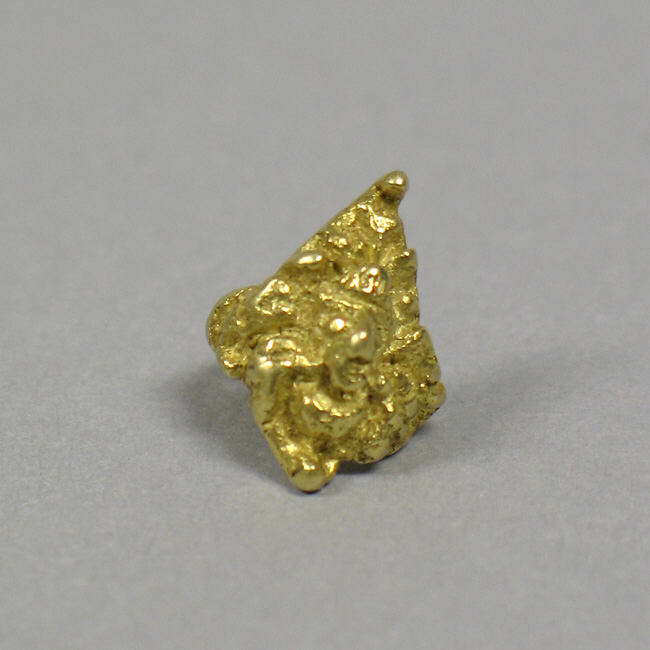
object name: ear ornament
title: Ear Ornament Garuda, Meru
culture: indonesian, central java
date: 701-1200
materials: gold